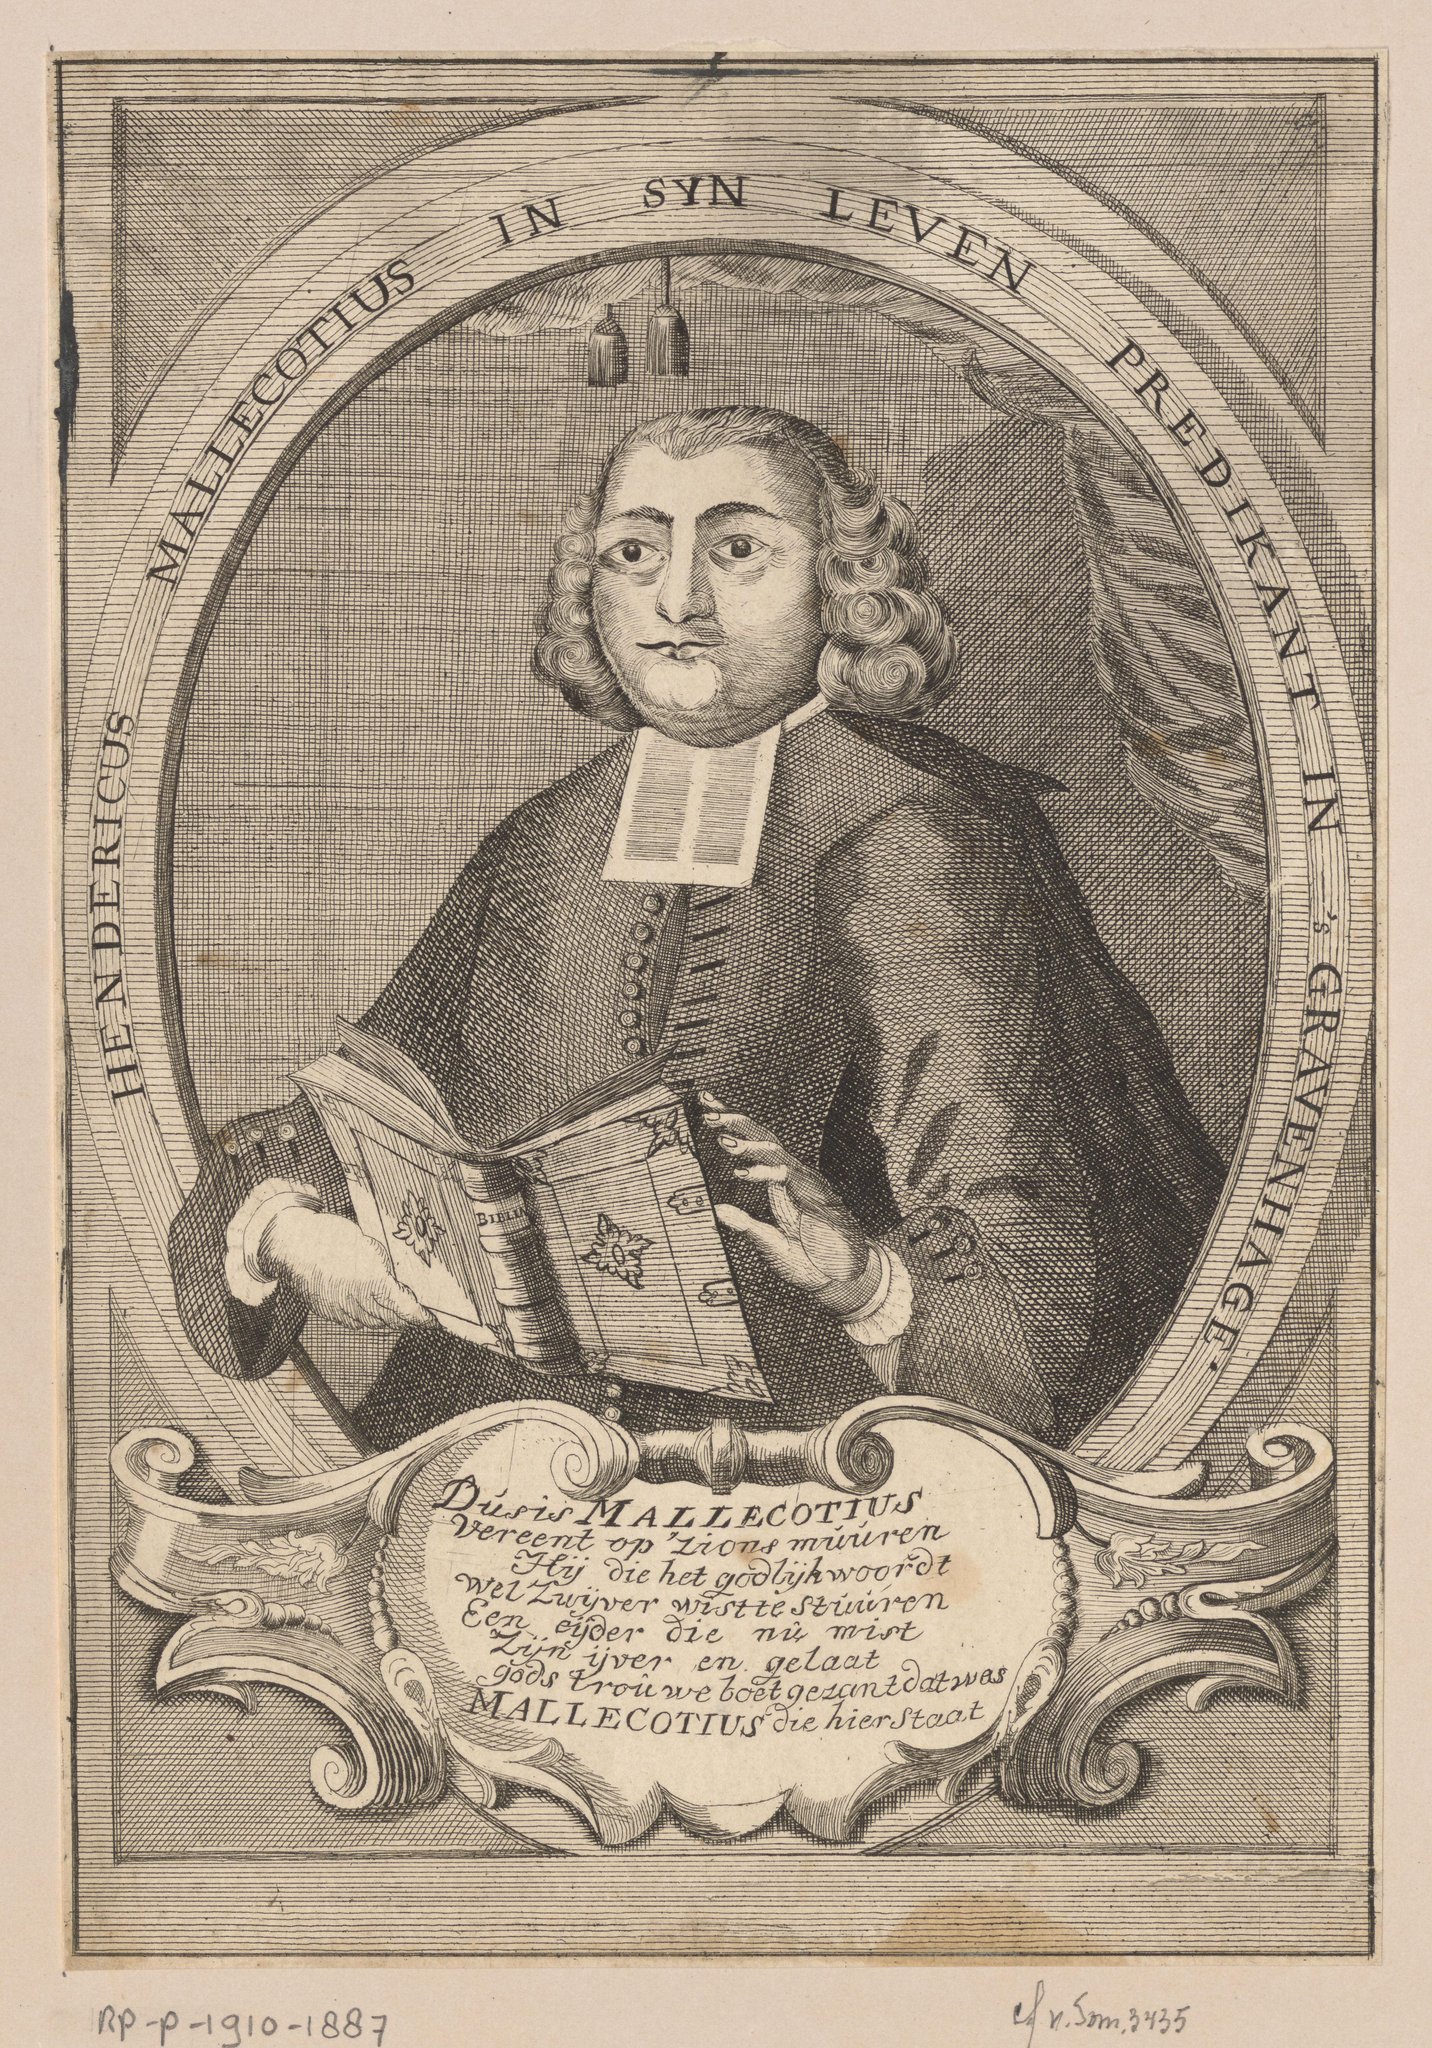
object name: print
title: Portret van Henricus Malecotius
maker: Anonymous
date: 1744-1780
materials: paper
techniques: engraving, etching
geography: northern netherlands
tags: ornament ~ medallion, historical persons, ornament ~ cartouche, the bible as a book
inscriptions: collector's mark: Lugt 2228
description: Met tekst rondom het portret en achtregelig vers onder het portret in het Nederlands.